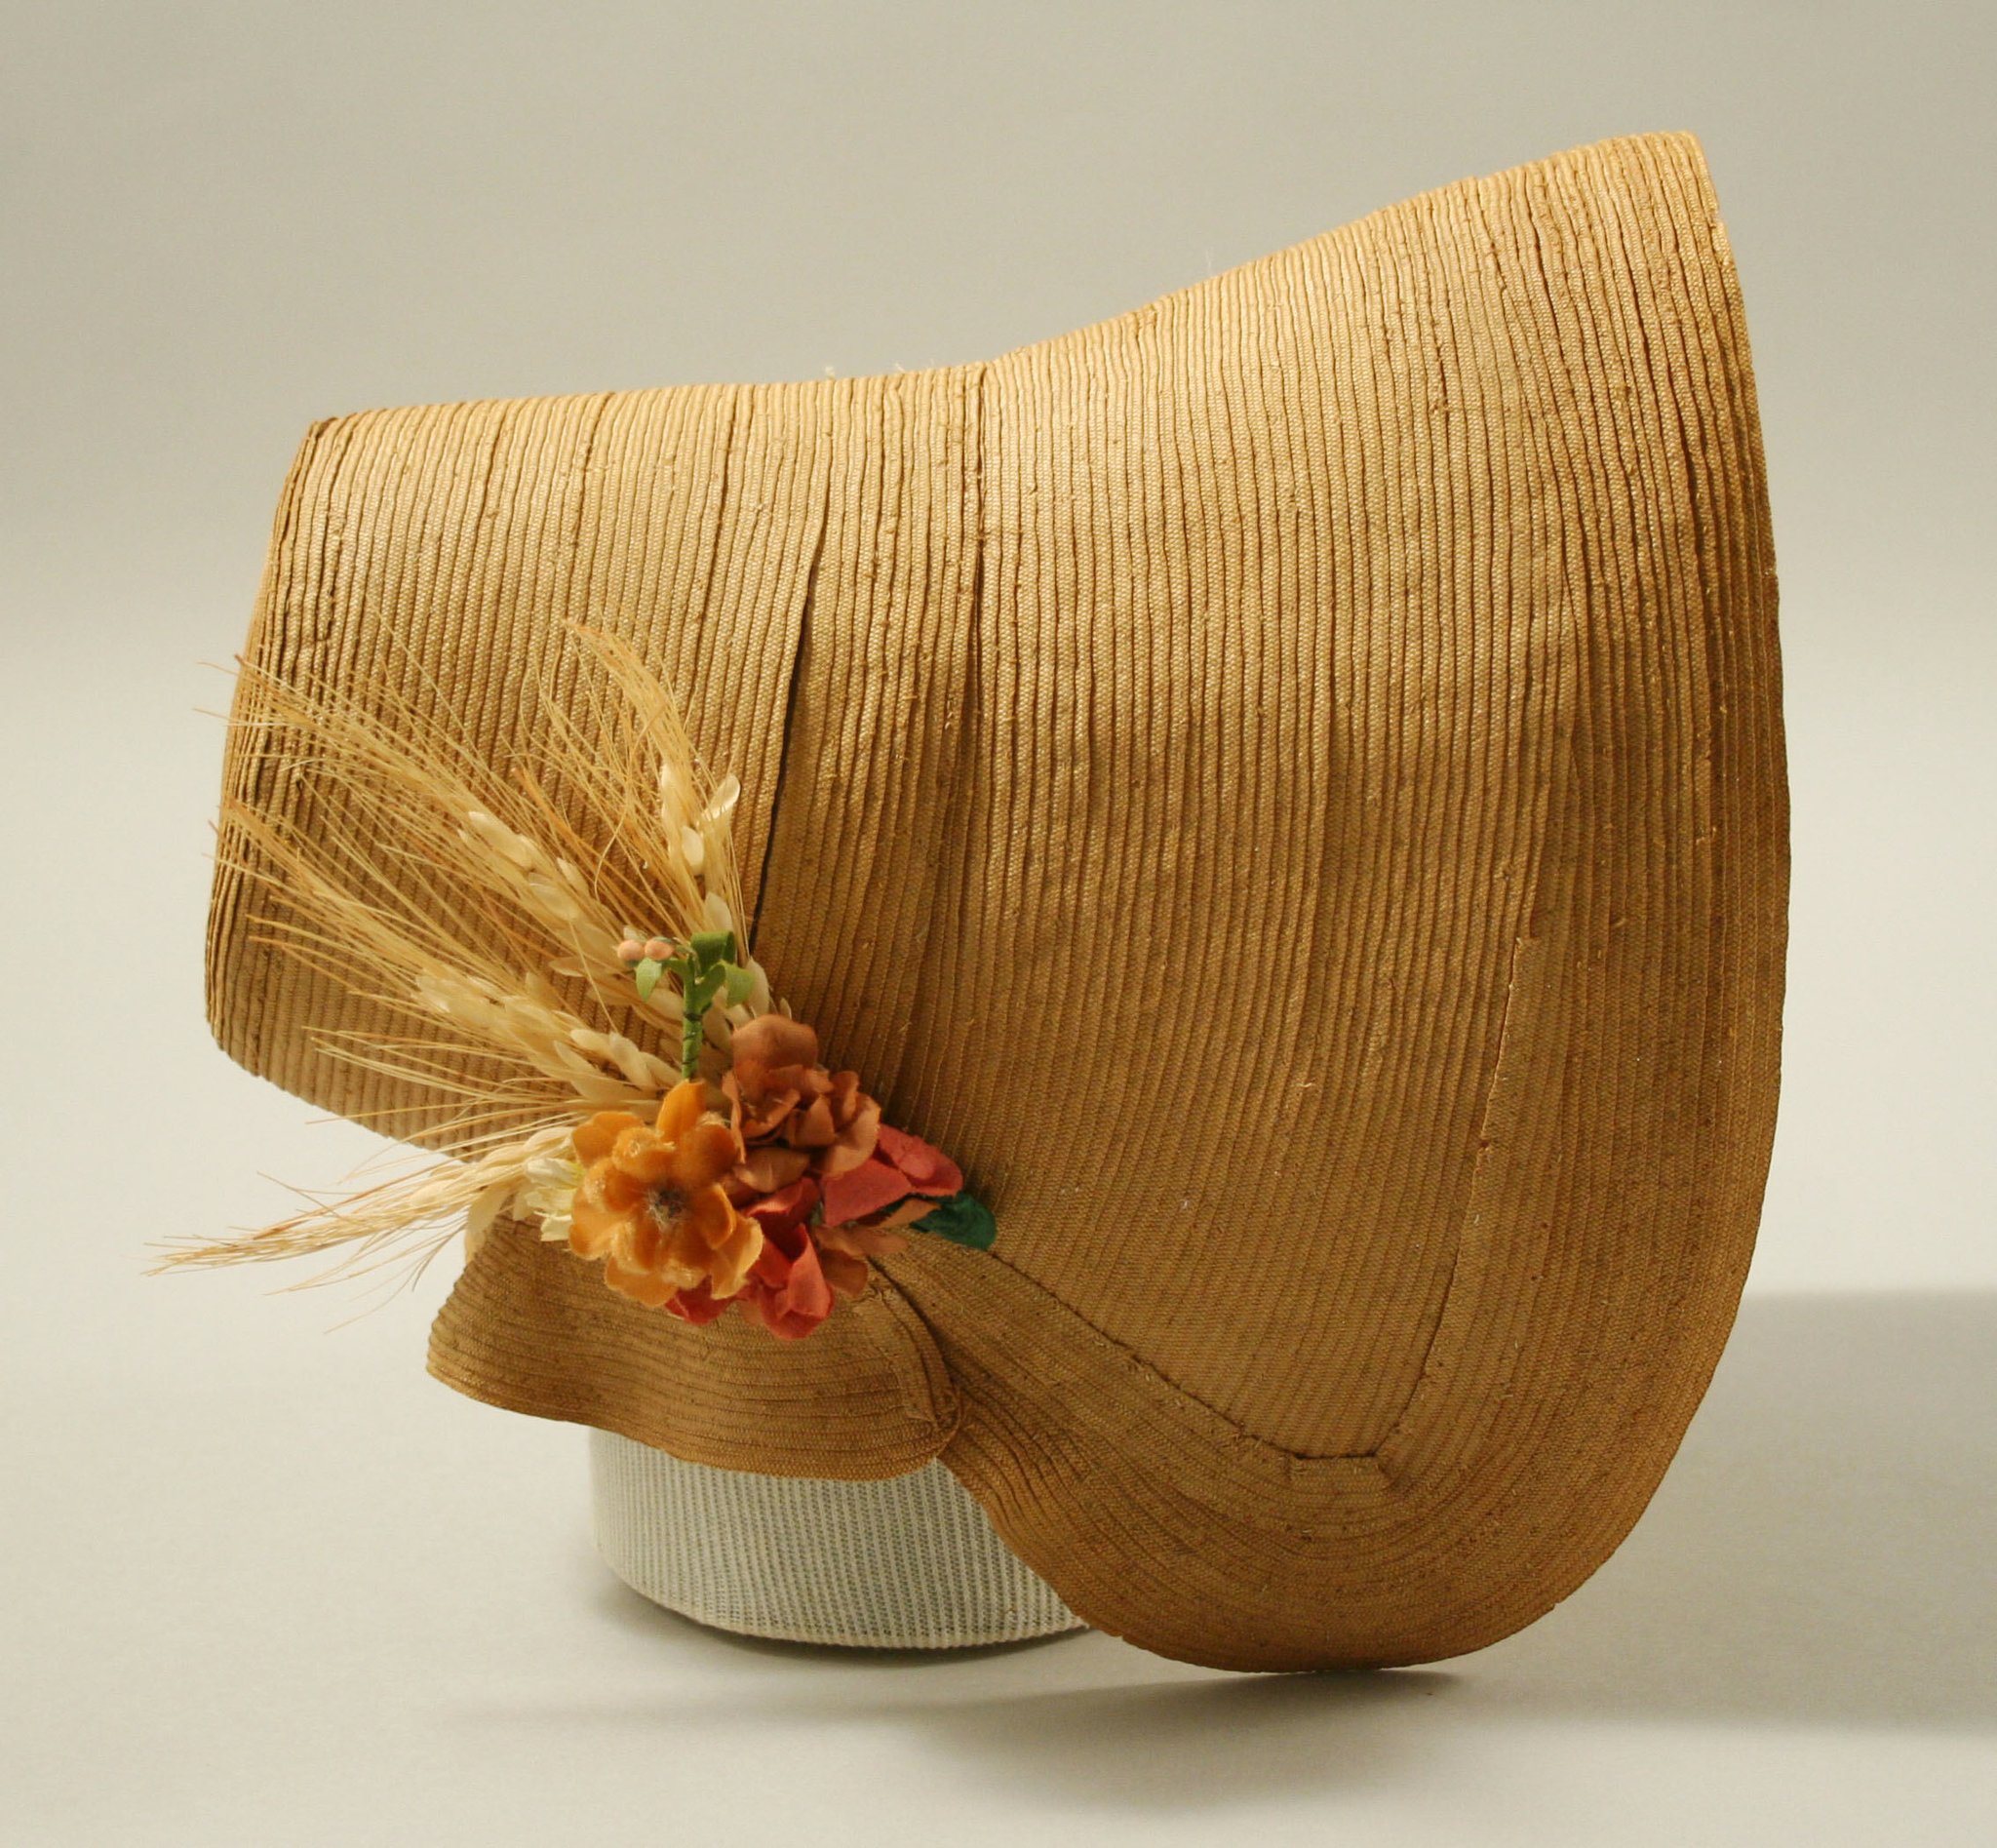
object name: hat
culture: american or european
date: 1801-1900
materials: fiber